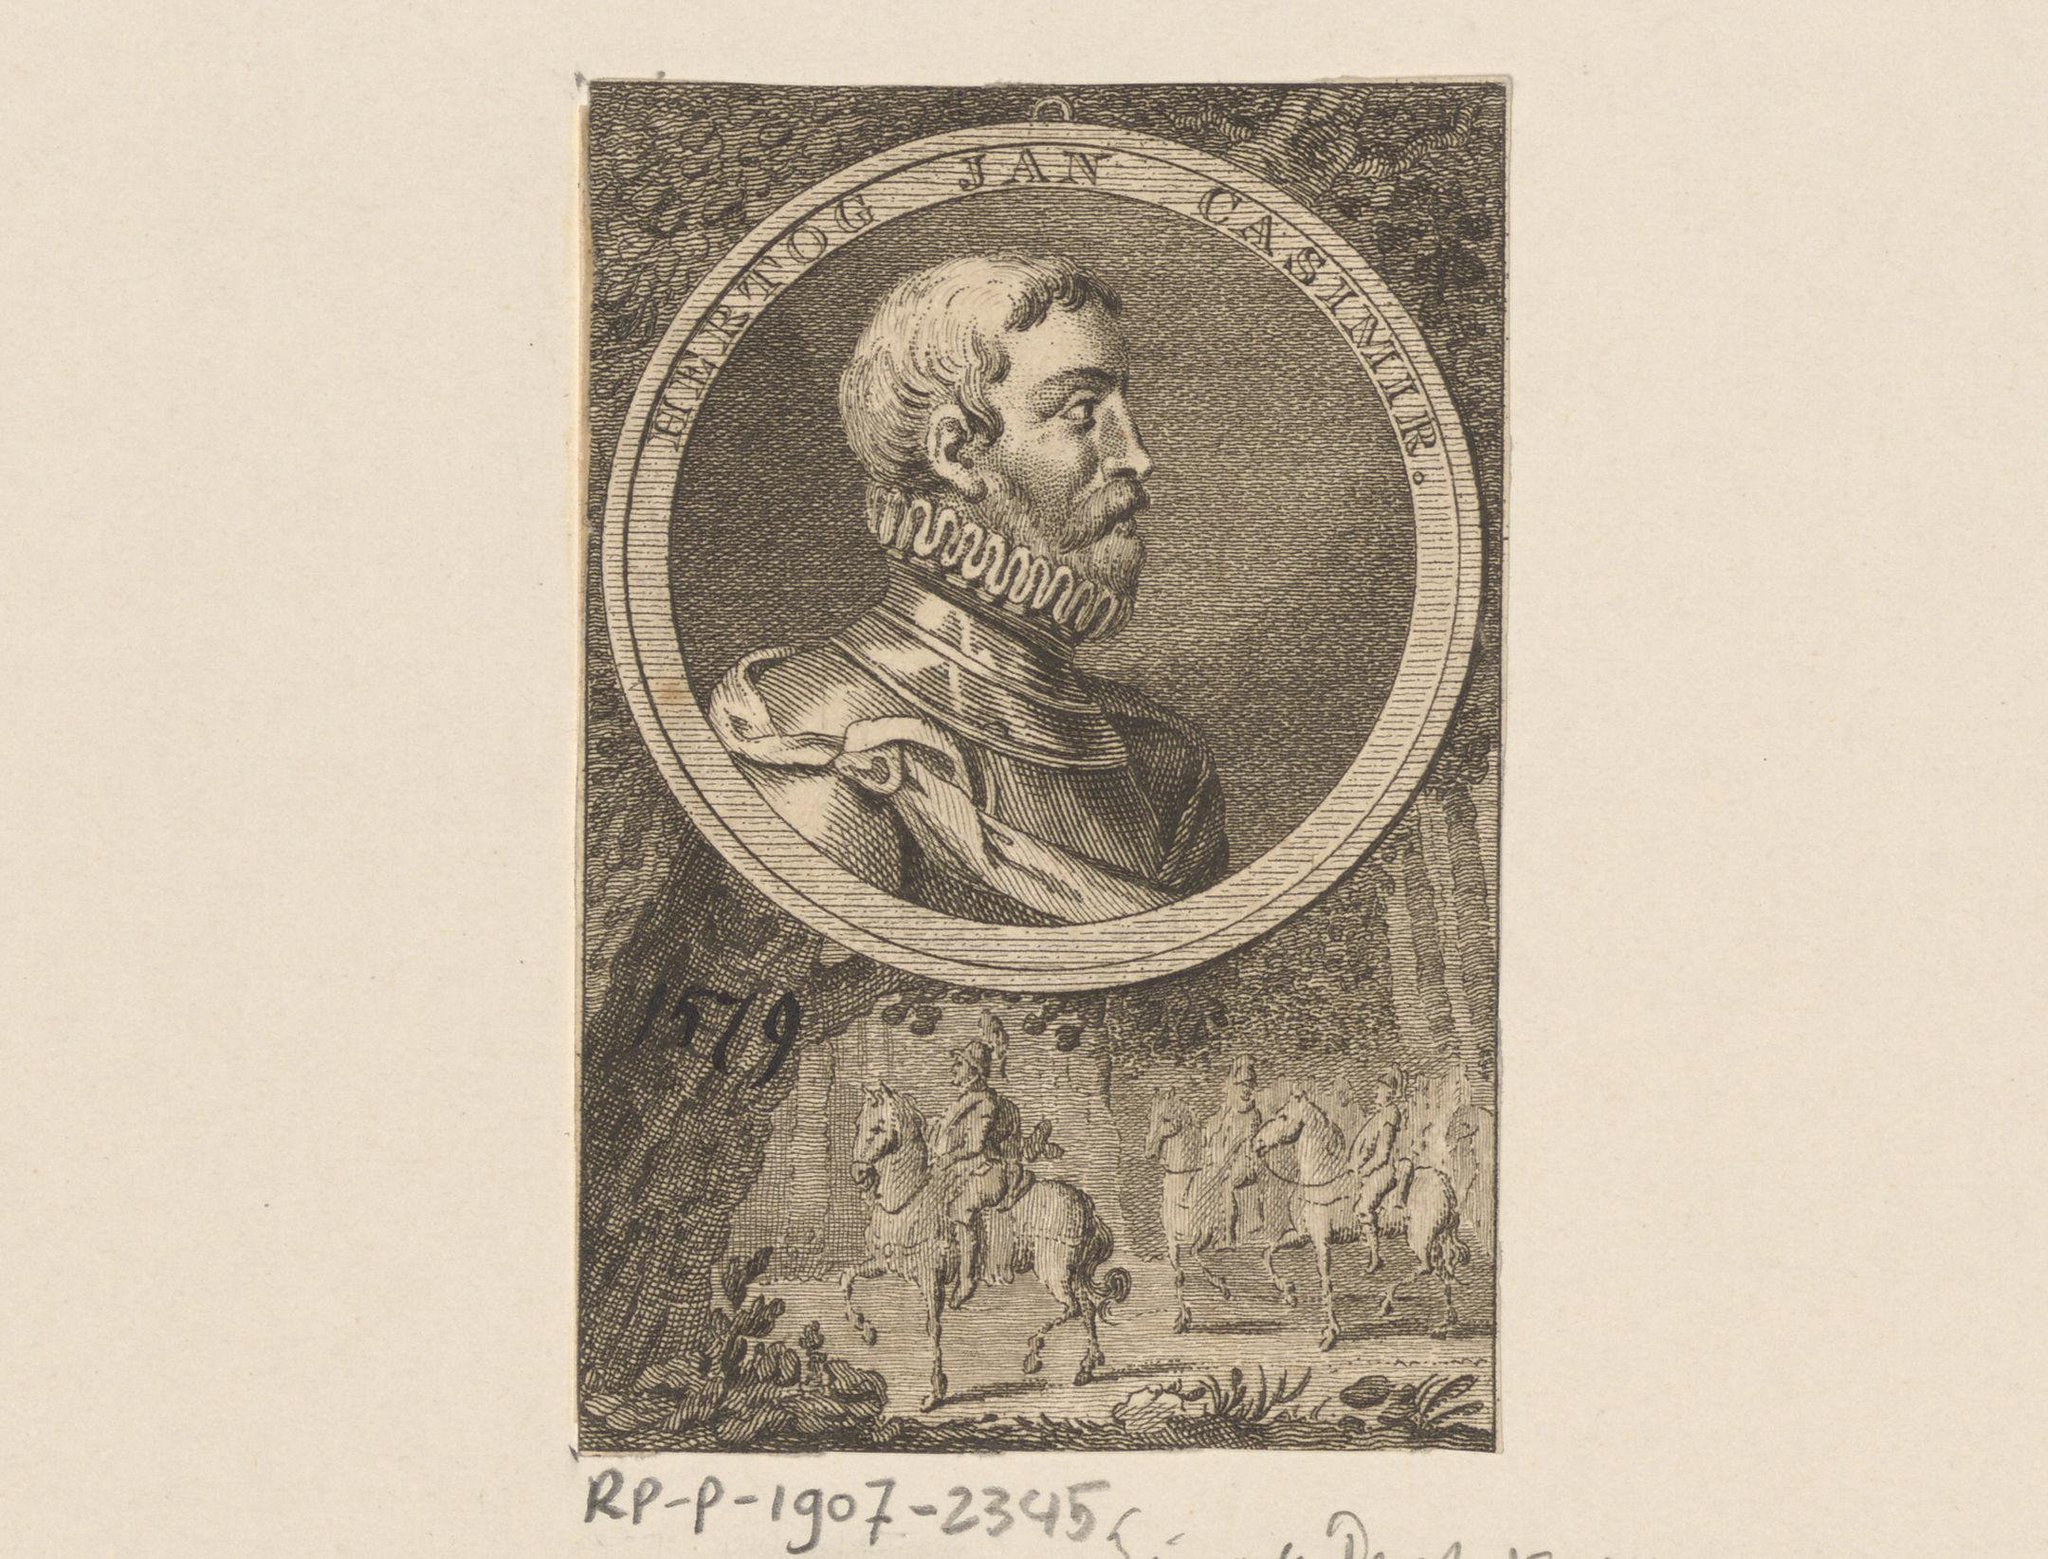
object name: print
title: Portret van Johan Casimir van Palts-Lautern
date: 1783-1795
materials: paper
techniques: engraving, etching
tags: riding a horse, ass, or mule; rider, horseman, commander-in-chief, general, marshal, historical persons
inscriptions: collector's mark: Lugt 2228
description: Prent mogelijk uit: Fokke, Jan. Geschiedenissen der Vereenigde Nederlanden voor de vaderlandsche jeugd (...). Amsterdam: Johannes Allart, 1783-1795, dl. 5.